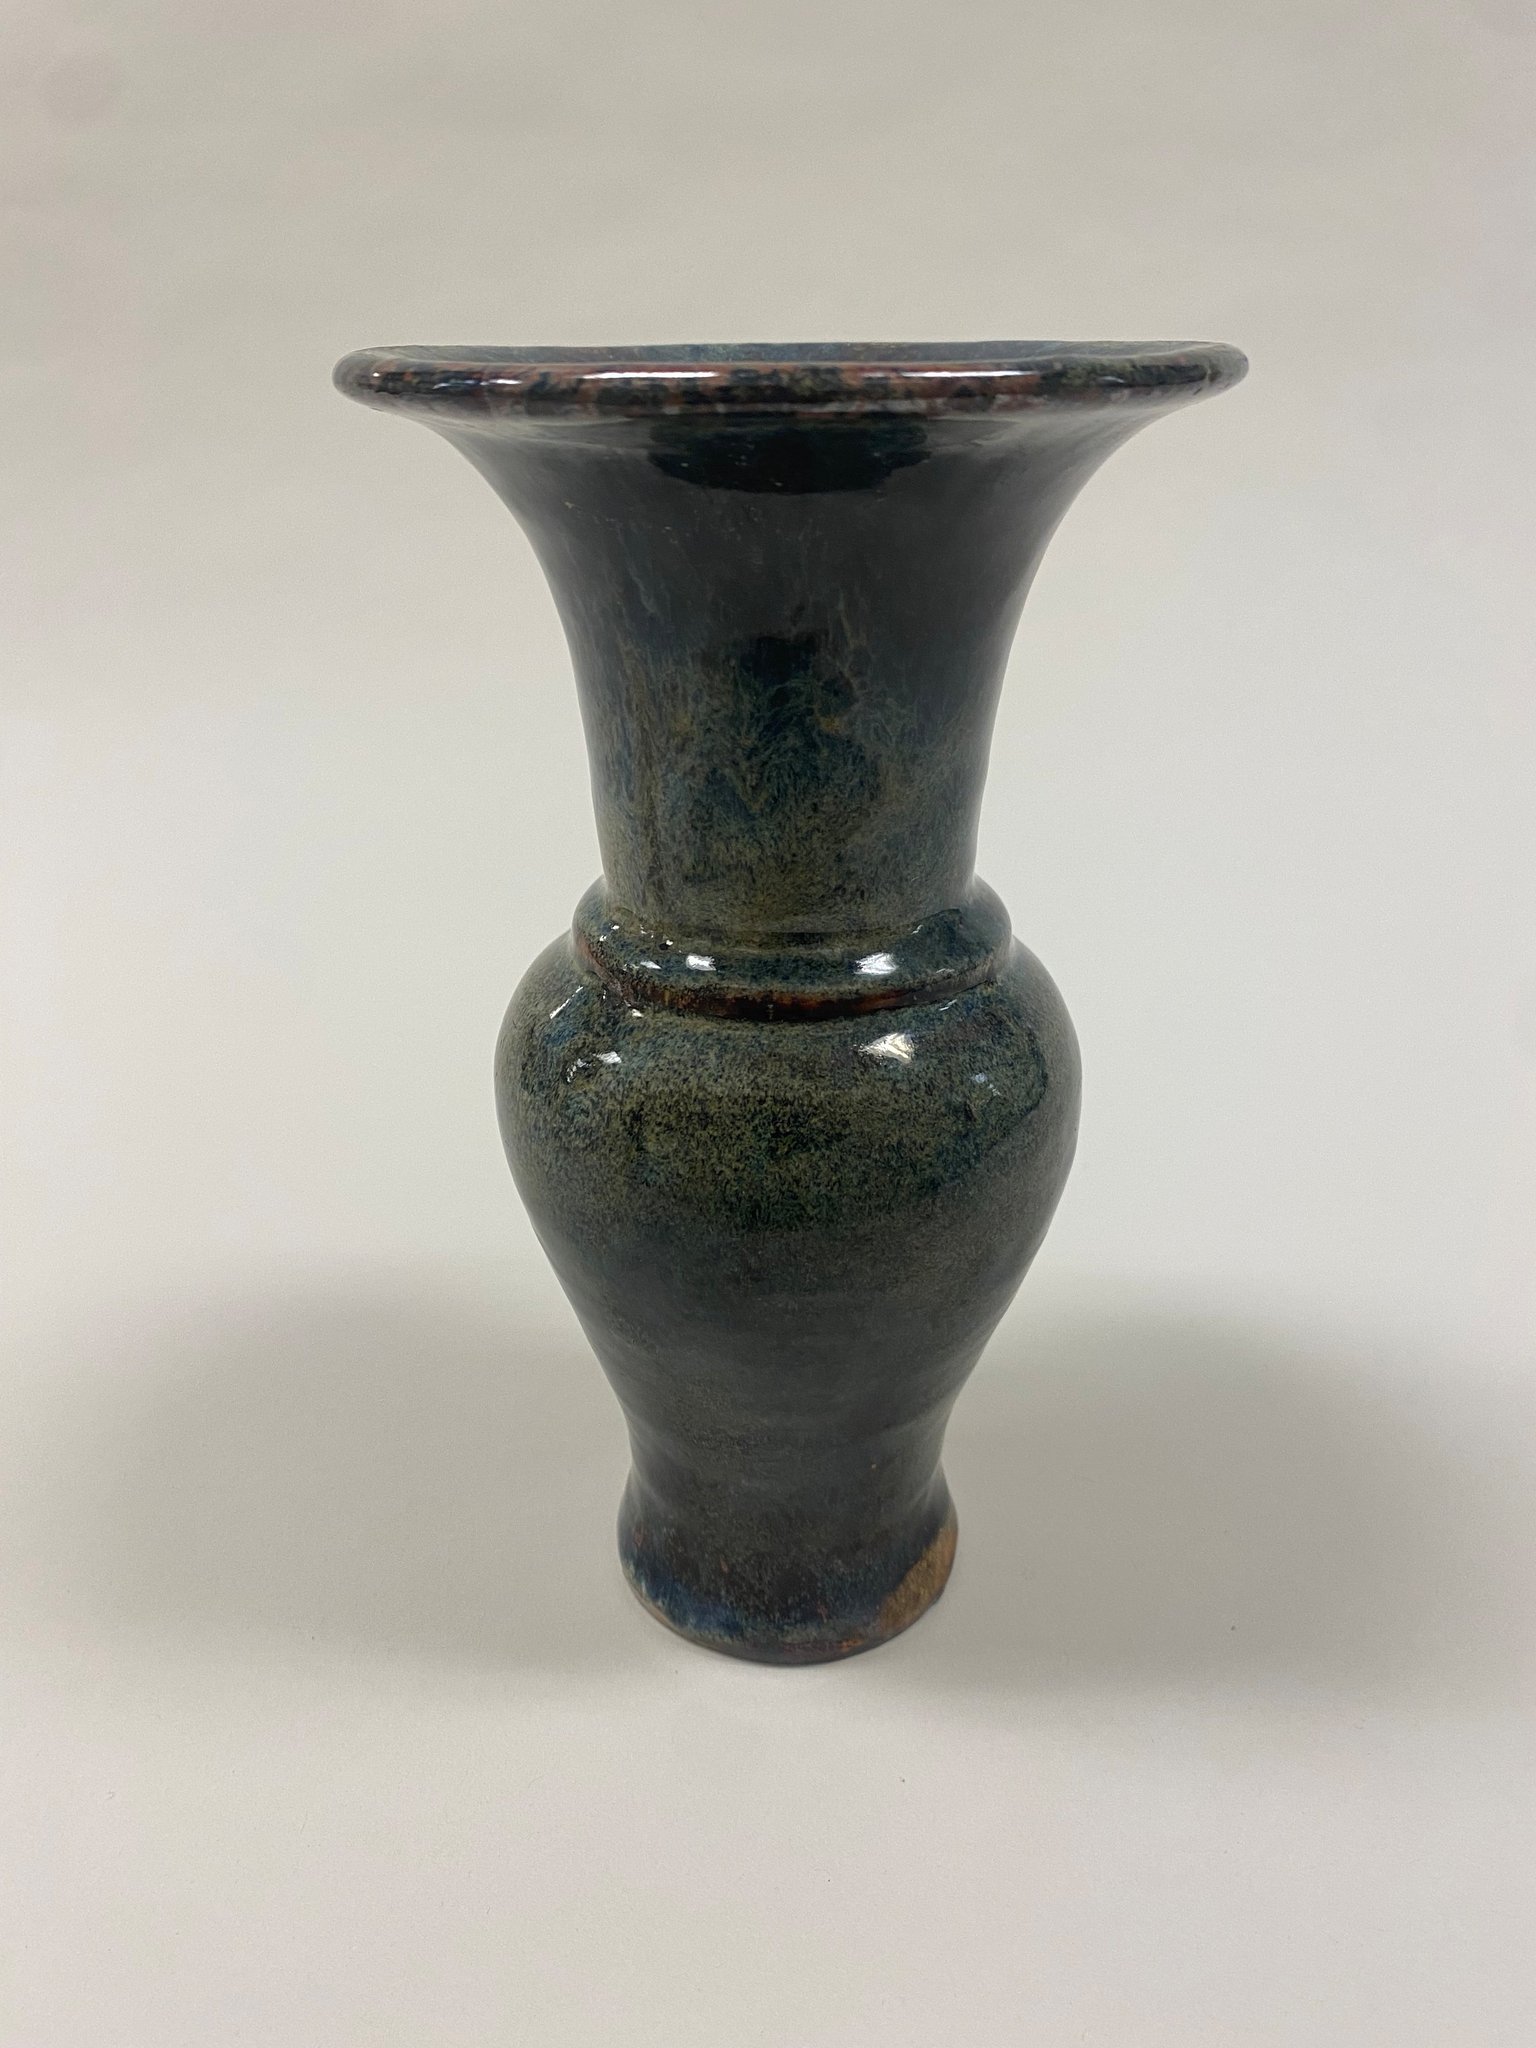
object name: vase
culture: chinese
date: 1701-1800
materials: glaze, stoneware